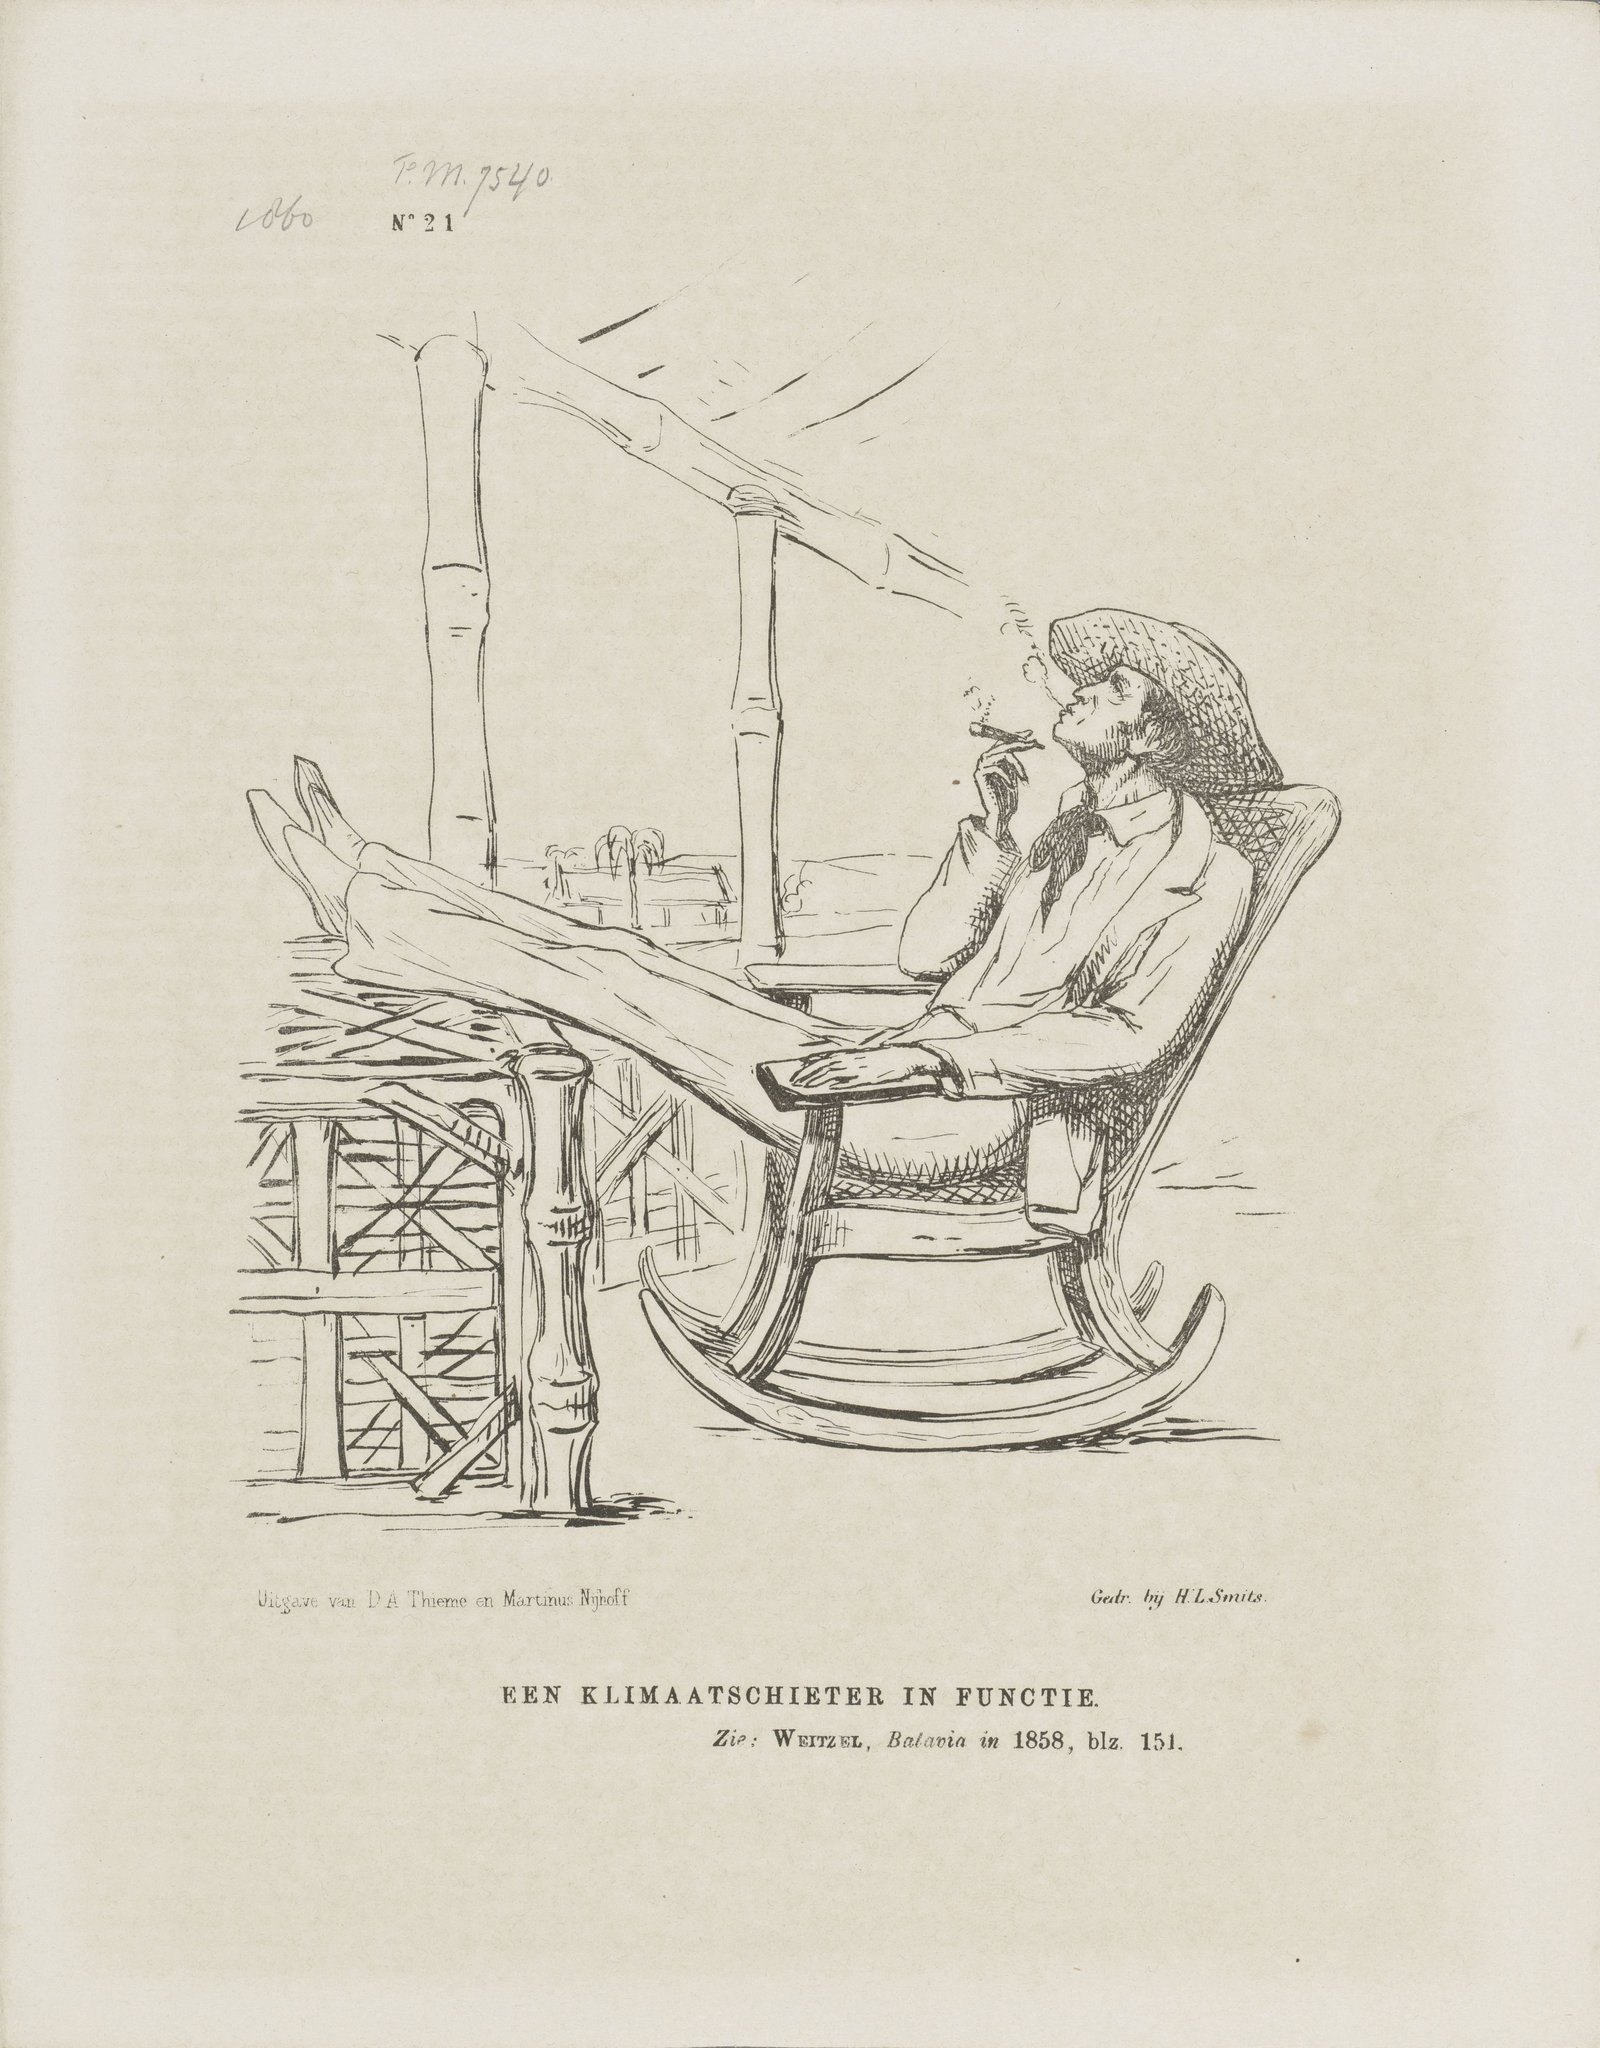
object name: print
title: Een klimaatschieter in functie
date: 1860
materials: paper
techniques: lithograph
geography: netherlands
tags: batavia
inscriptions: collector's mark: Lugt 2228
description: Spotprent op het werk van kolonel A.W.P. Weitzel in Batavia. De Kolonel zittend rokend in een schommelstoel op een veranda. Plaat verschenen bij het weekblad De Nederlandsche Spectator, nr. 21, 26 mei 1860.